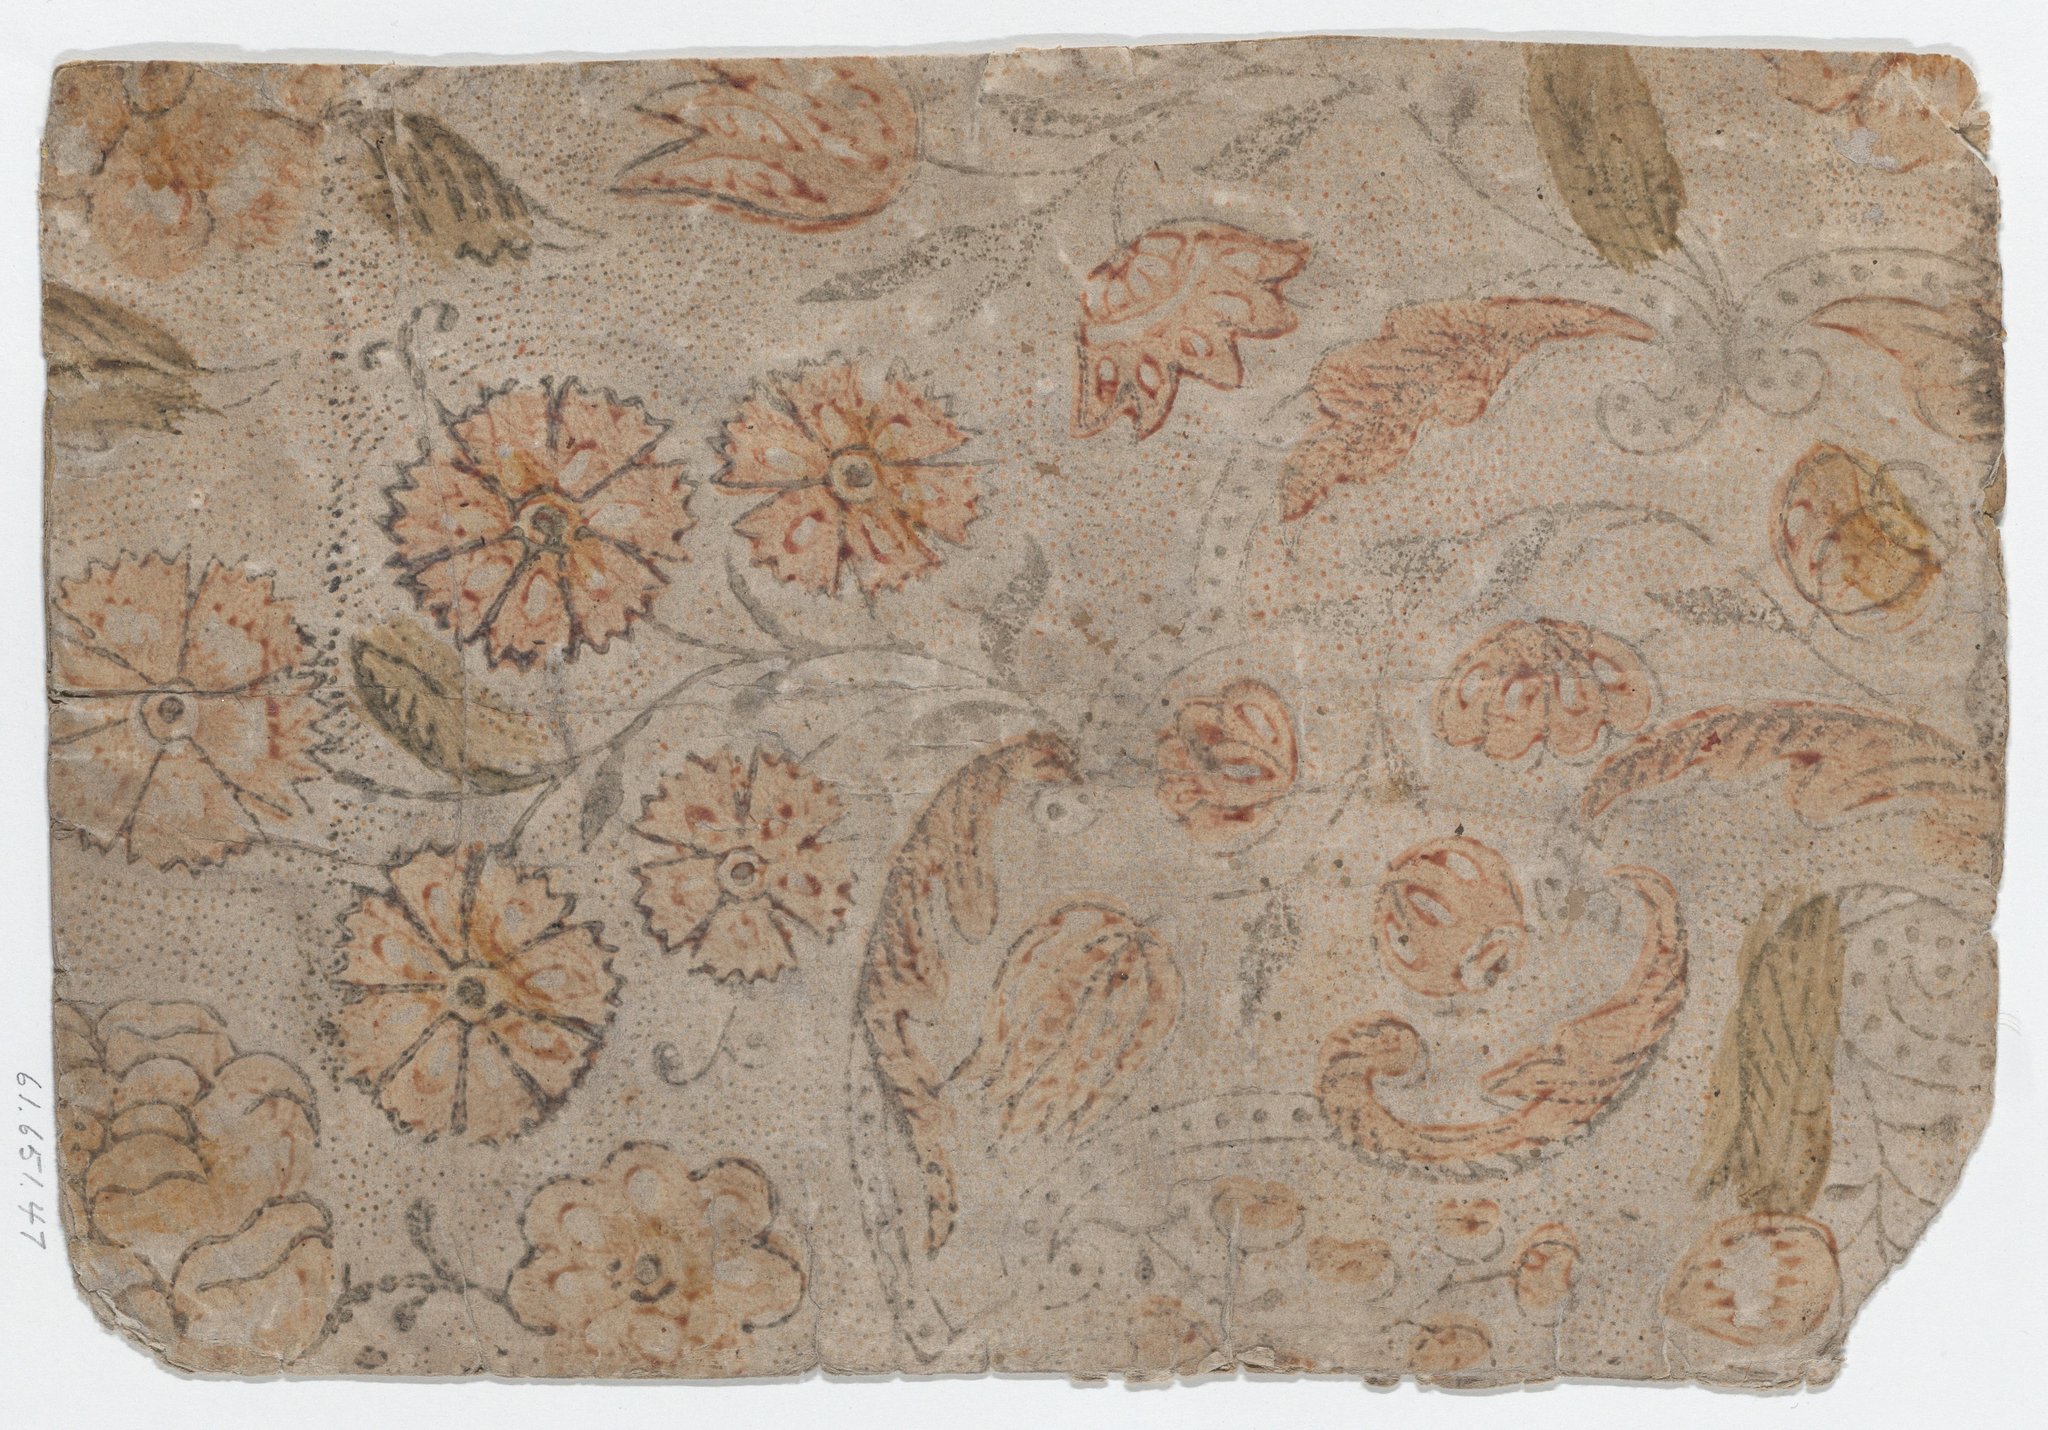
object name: print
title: Sheet with floral and dot pattern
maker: Anonymous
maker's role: artist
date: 1701-1800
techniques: relief print